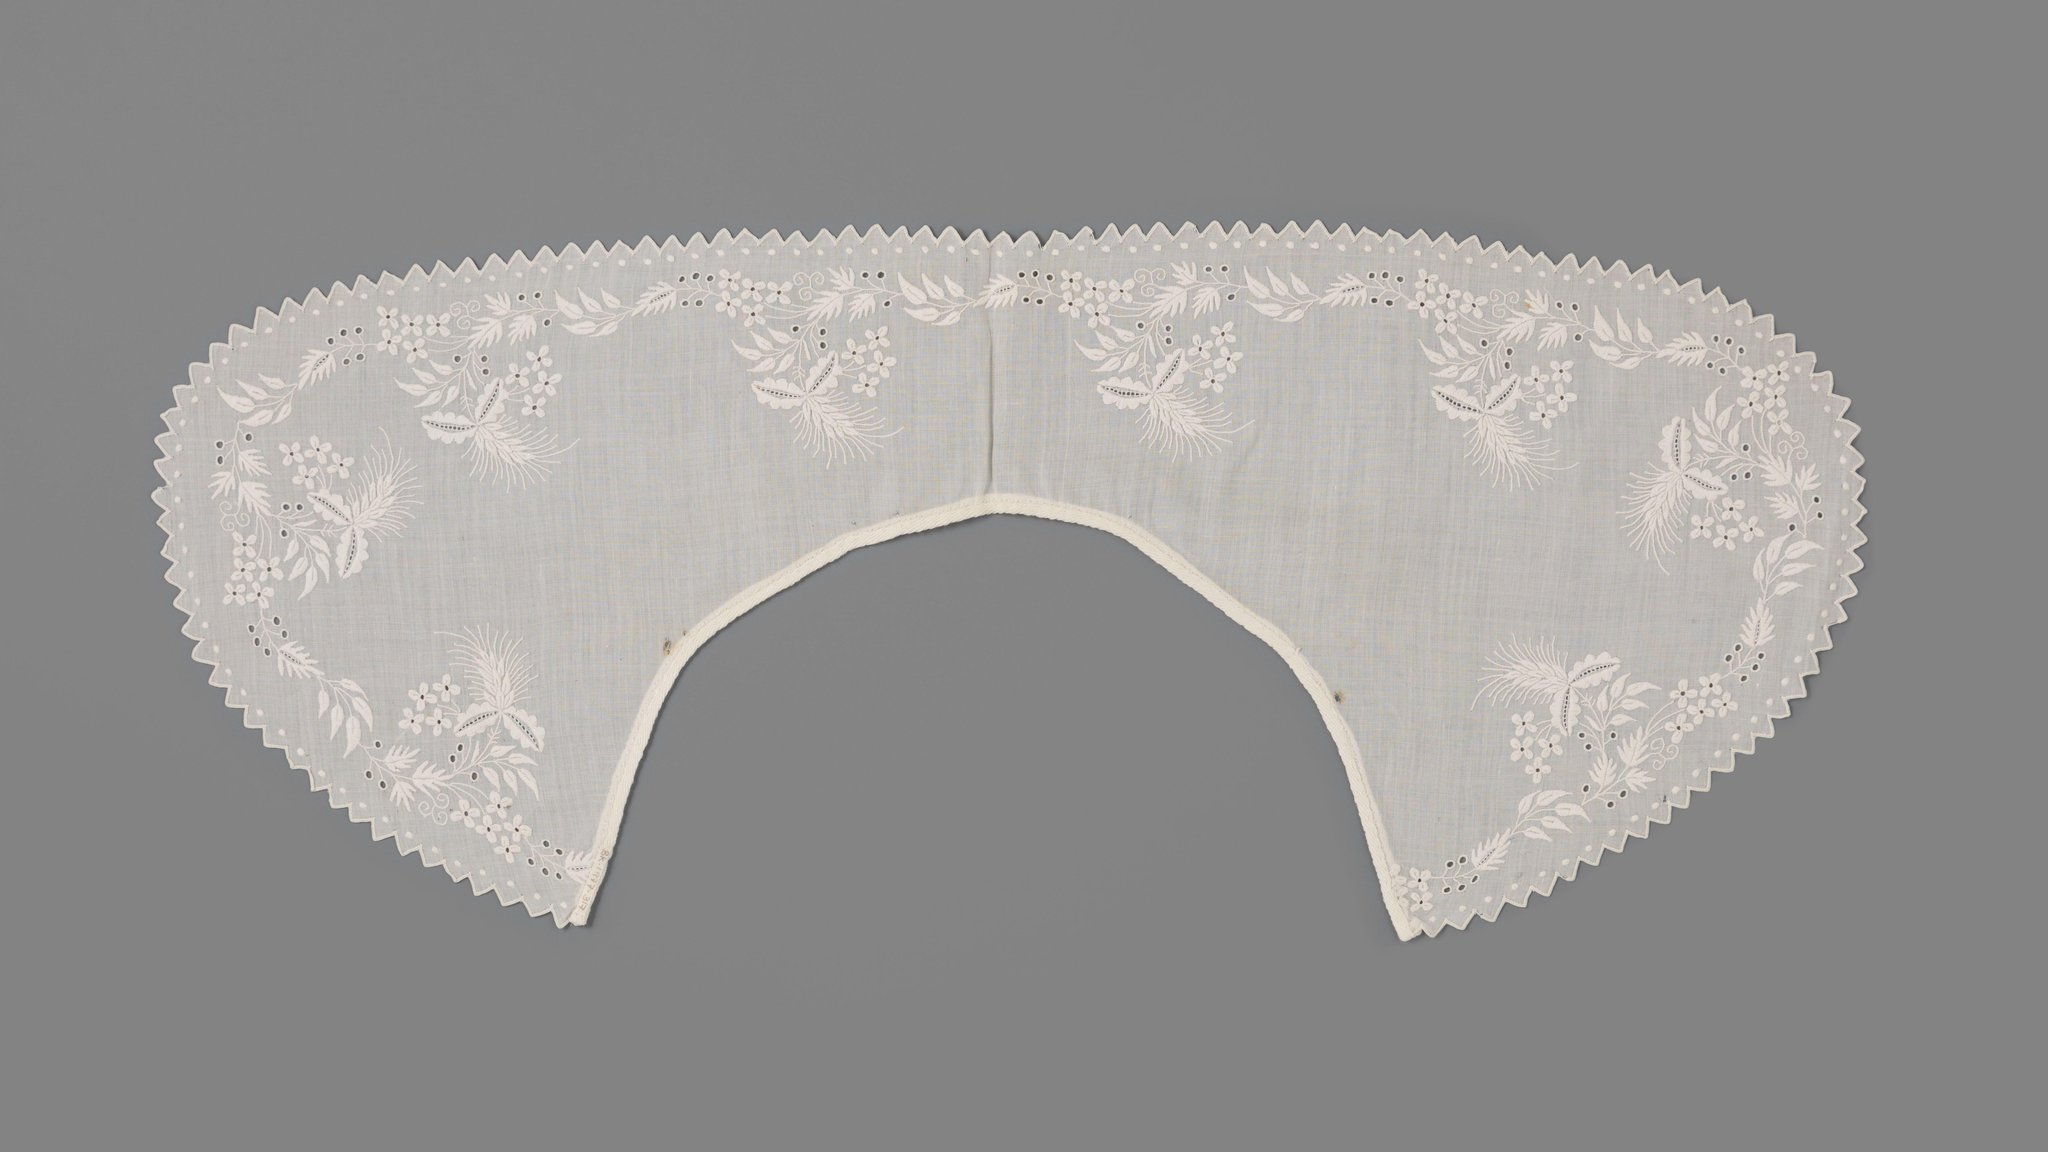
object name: collar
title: Kraag van katoenbatist met een kartelrand en met decoraties in witwerk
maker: Anonymous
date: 1830-1835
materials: cotton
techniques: embroidery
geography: netherlands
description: Platte kraag van katoenbatist met witwerk in de vorm van moesjes, bloem- en bladranken. Langs de nek is de kraag afgezet met band. Aan de buitenzijde heeft de kraag een kartelrand die is afgezet met festonsteken.